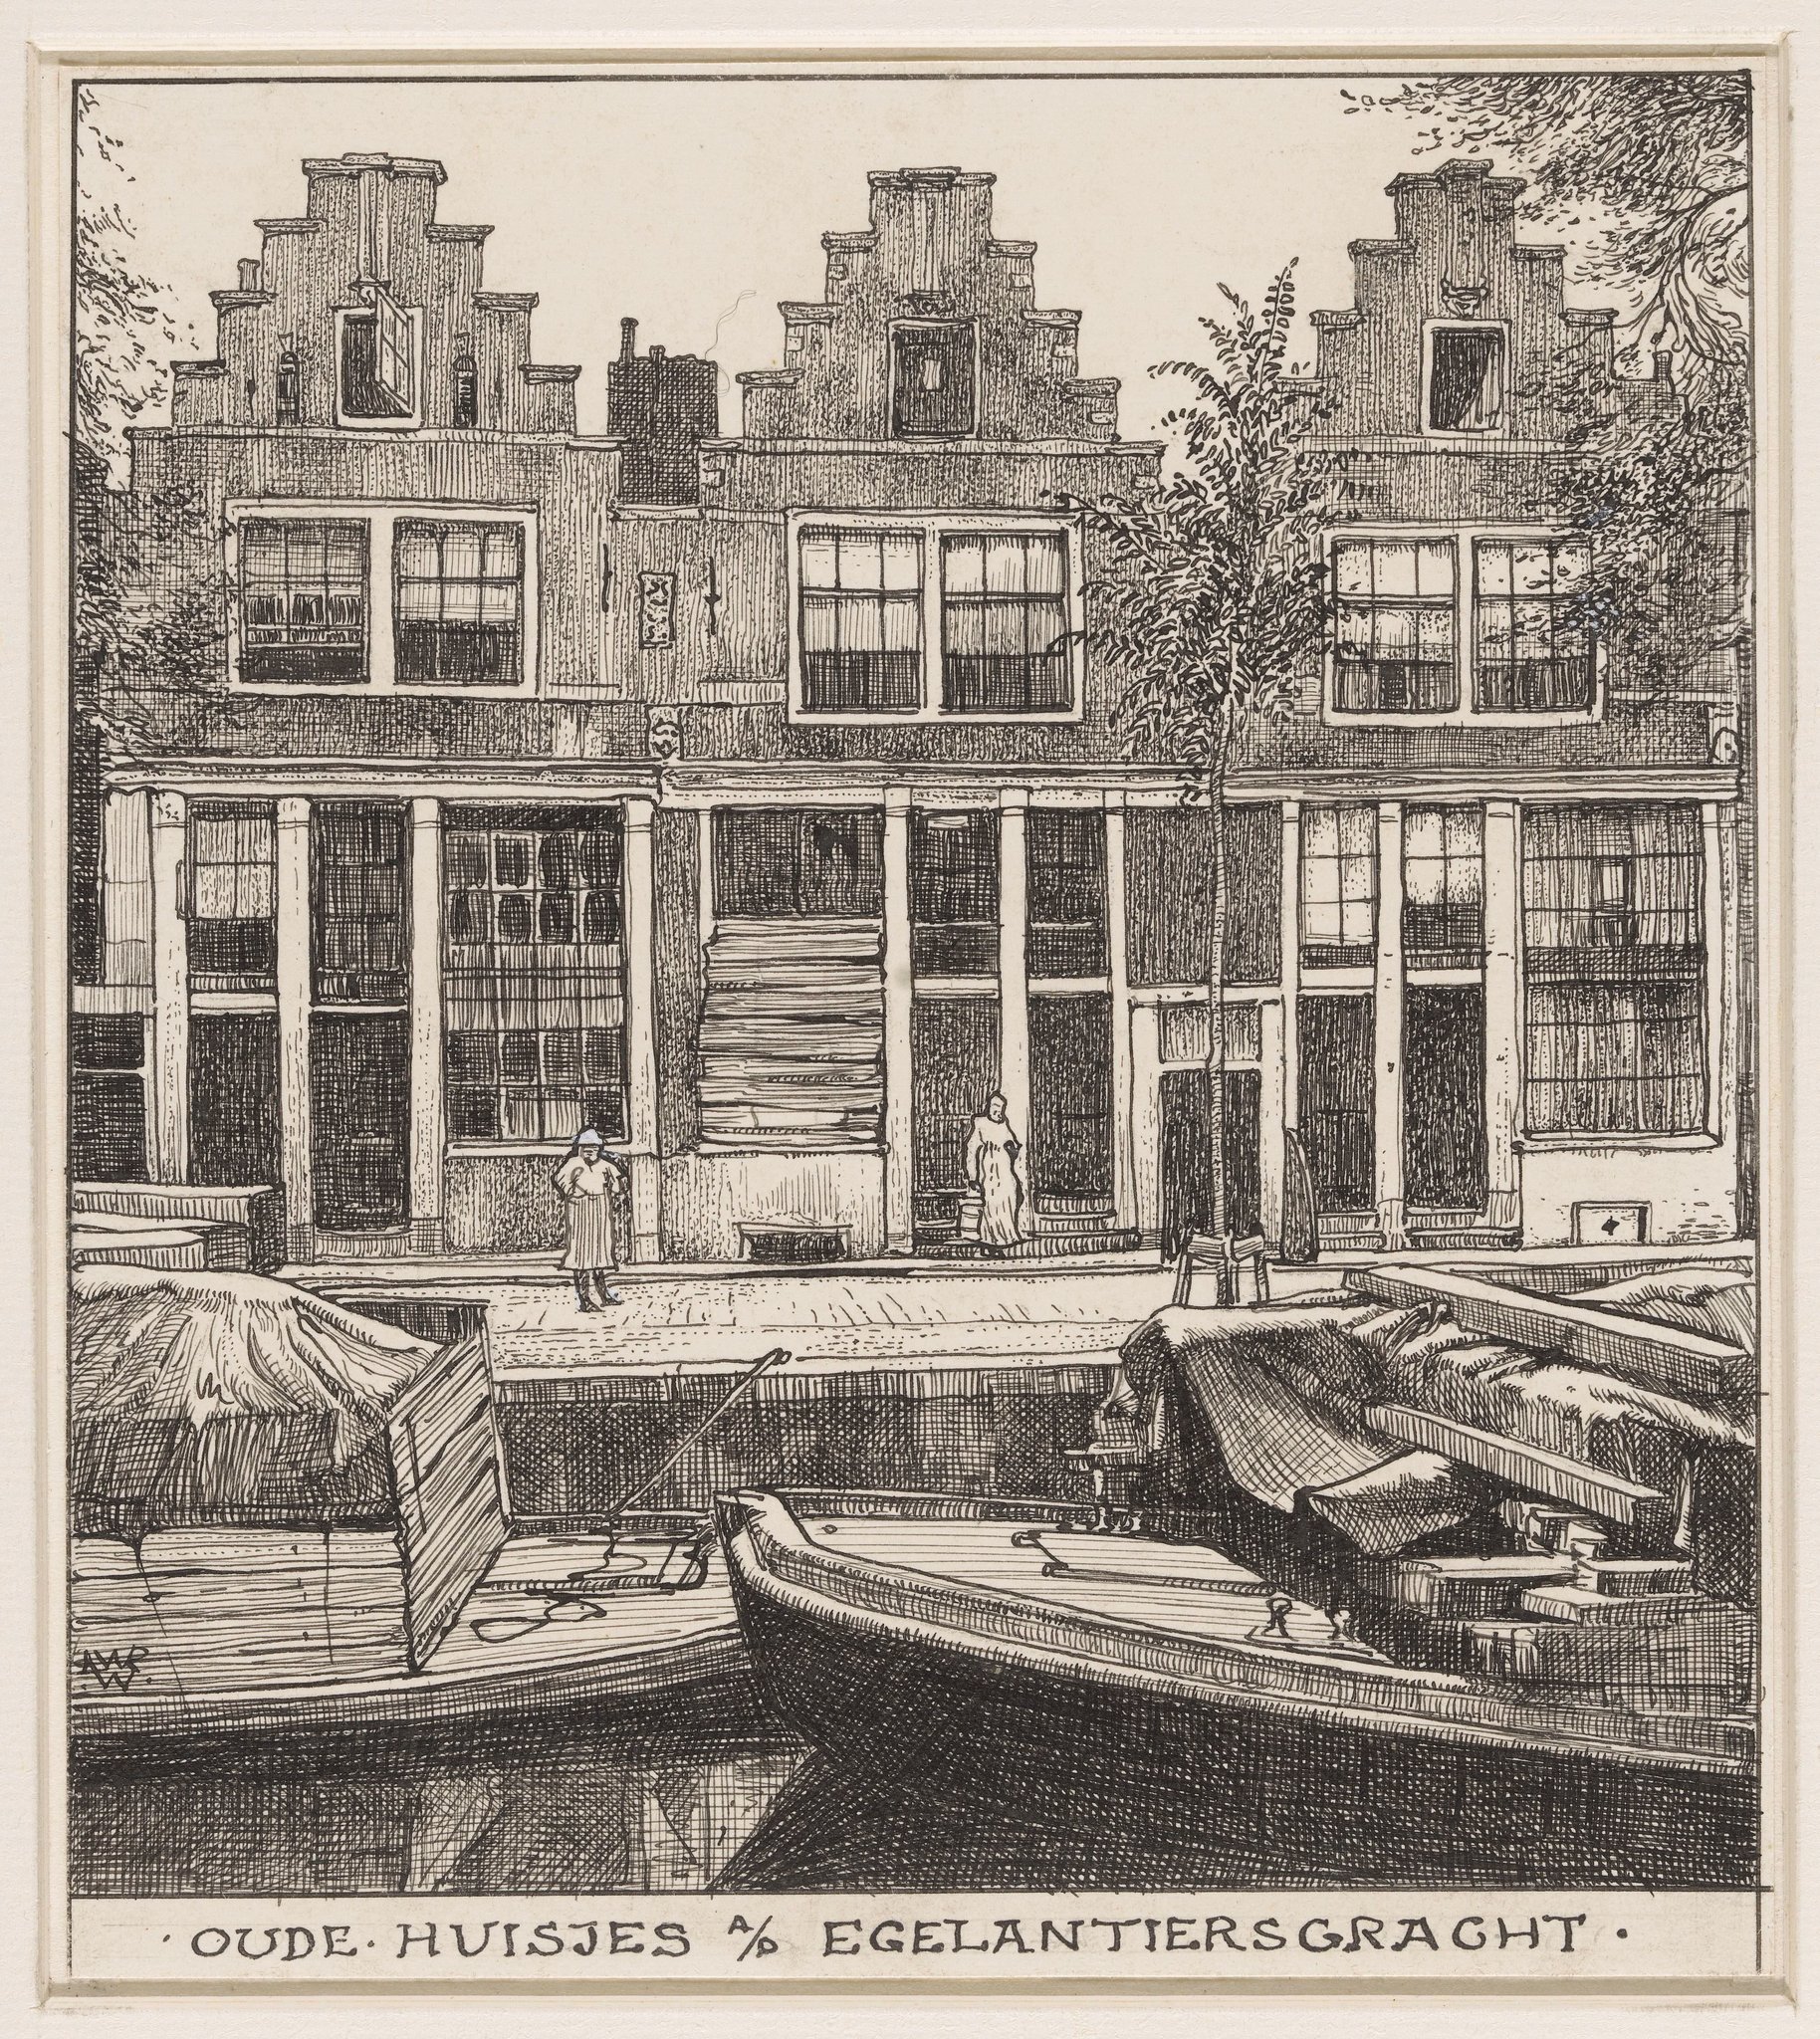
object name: drawing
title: Oude huisjes aan de Egelantiersgracht te Amsterdam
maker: willem wenckebach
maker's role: designer, draughtsman, painter, print maker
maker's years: 1860-1937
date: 1870-1926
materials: paint, ink, paper, pencil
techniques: pen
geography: amsterdam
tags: canals, waters (in city), amsterdam